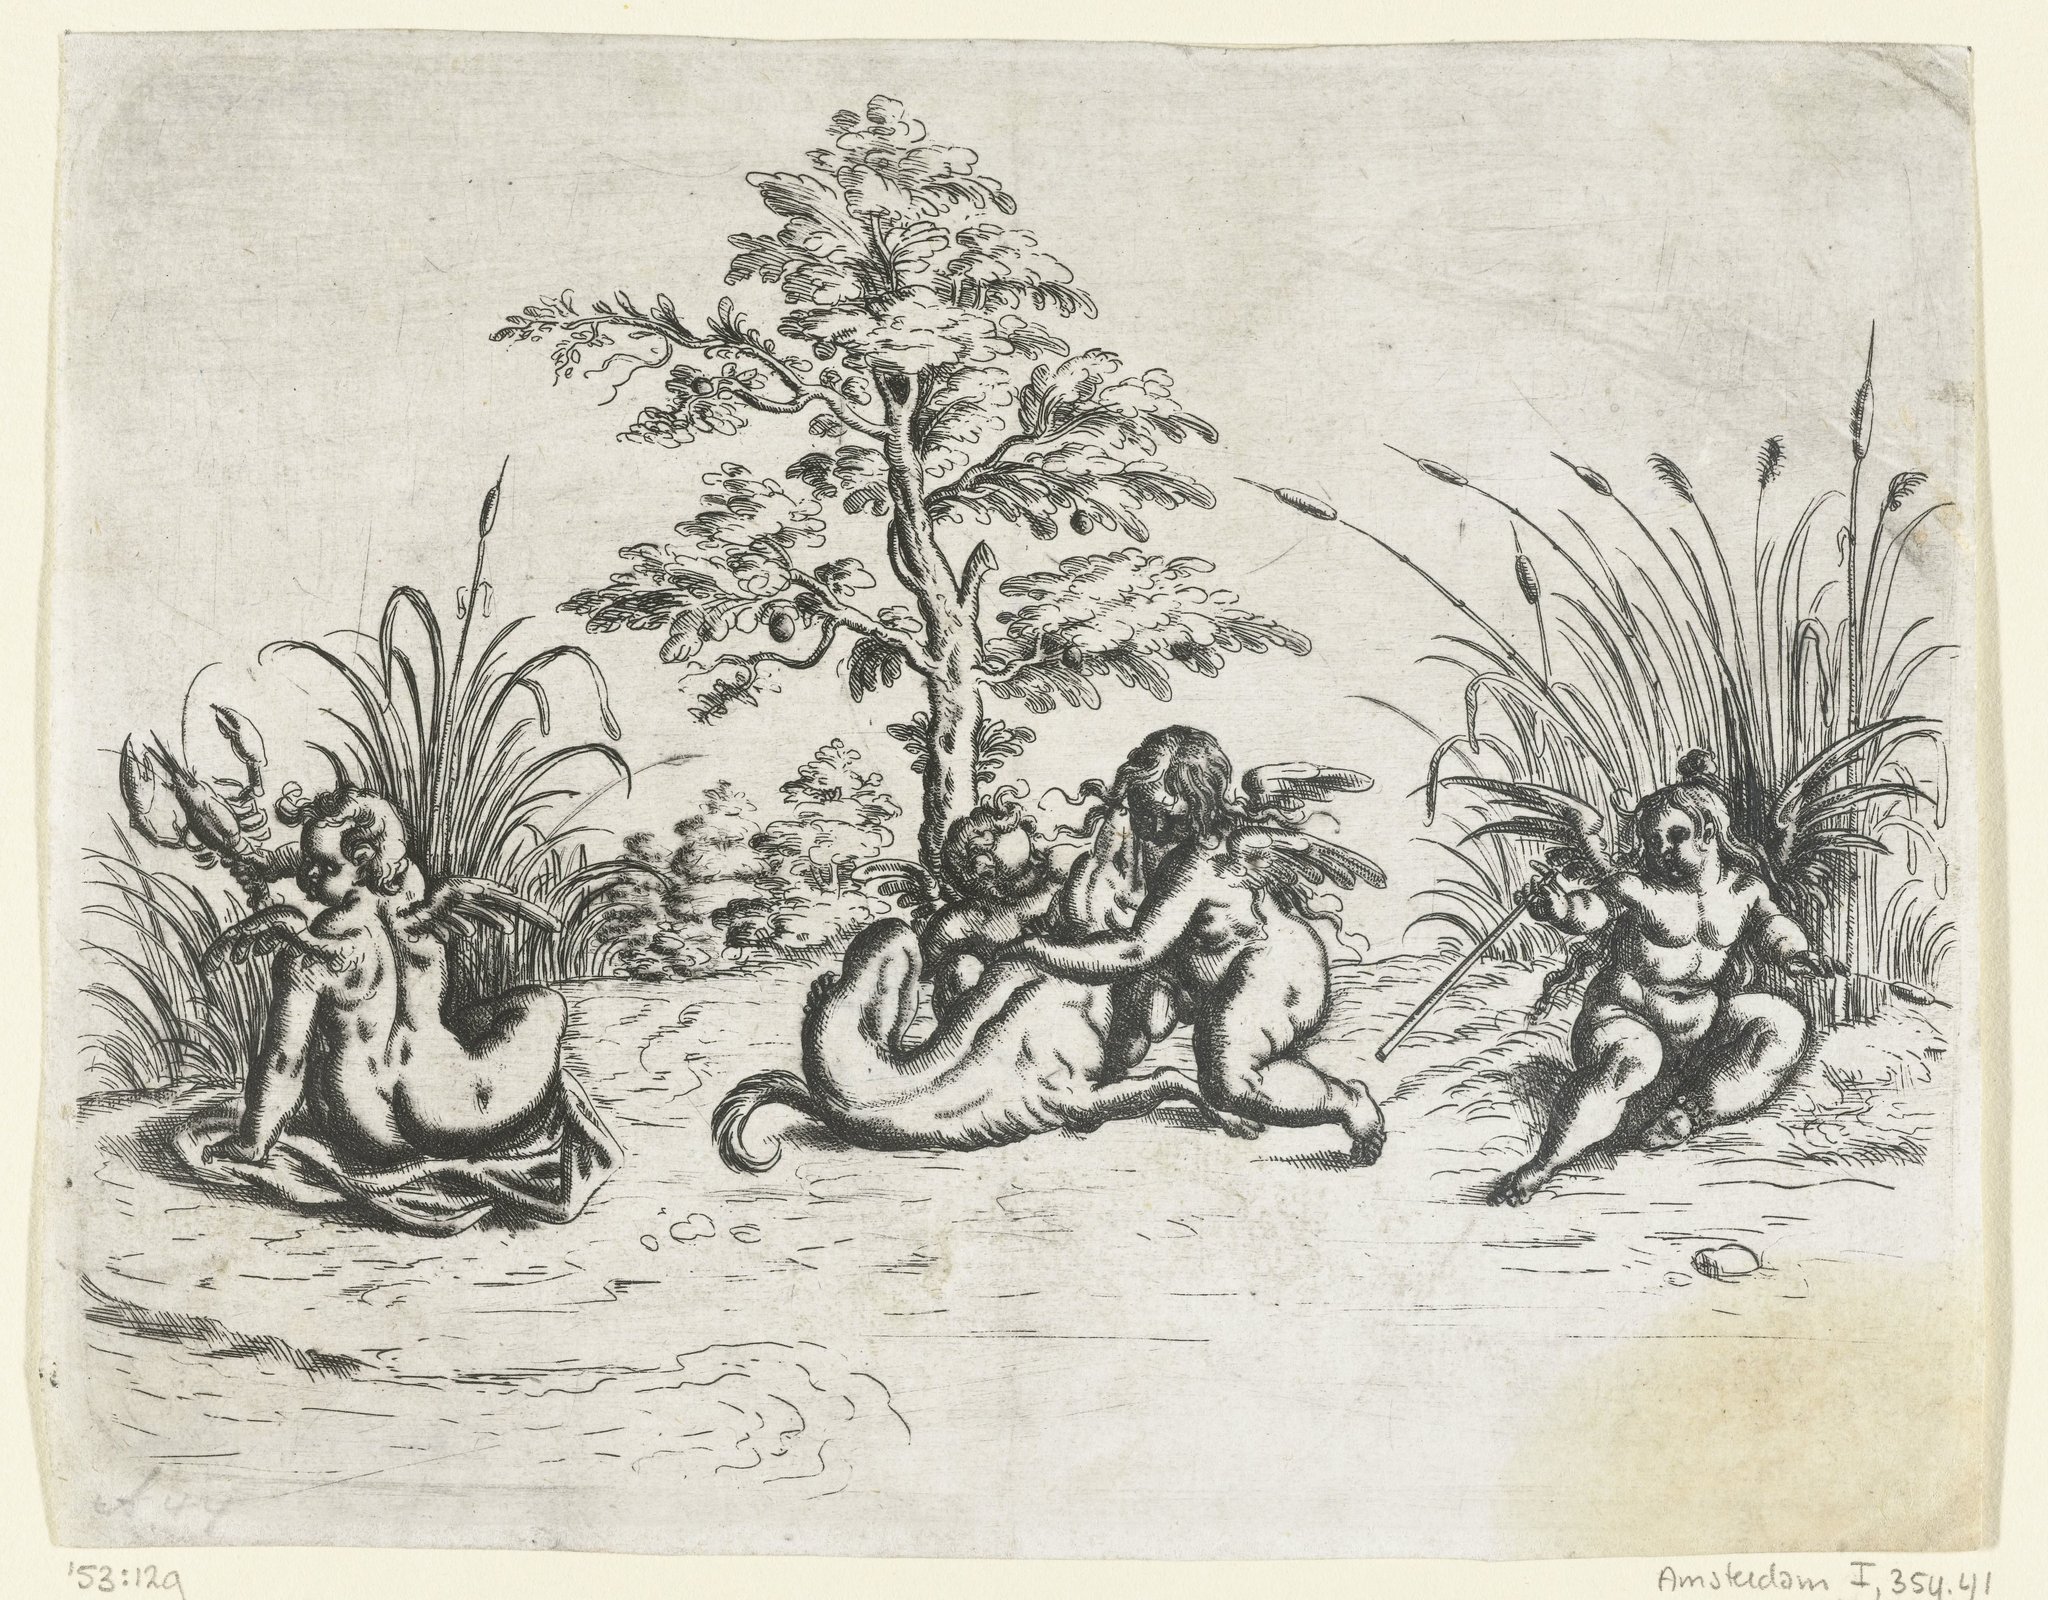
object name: ornament print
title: Vier putti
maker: christoph jamnitzer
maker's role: draughtsman, goldsmith, print maker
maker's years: 1563-1618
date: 1573-1610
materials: paper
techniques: etching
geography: germany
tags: dog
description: In het midden twee putti die onder een boom met een hond spelen. Blad uit een serie vlakdecoraties met grotesken, cartouches, ovalen, mascarons, putti en fantastische wezens. De serie bestaat uit drie titelbladen, twee tekstbladen met de opdracht en het voorwoord en 60 bladen, verdeeld over drie boeken.